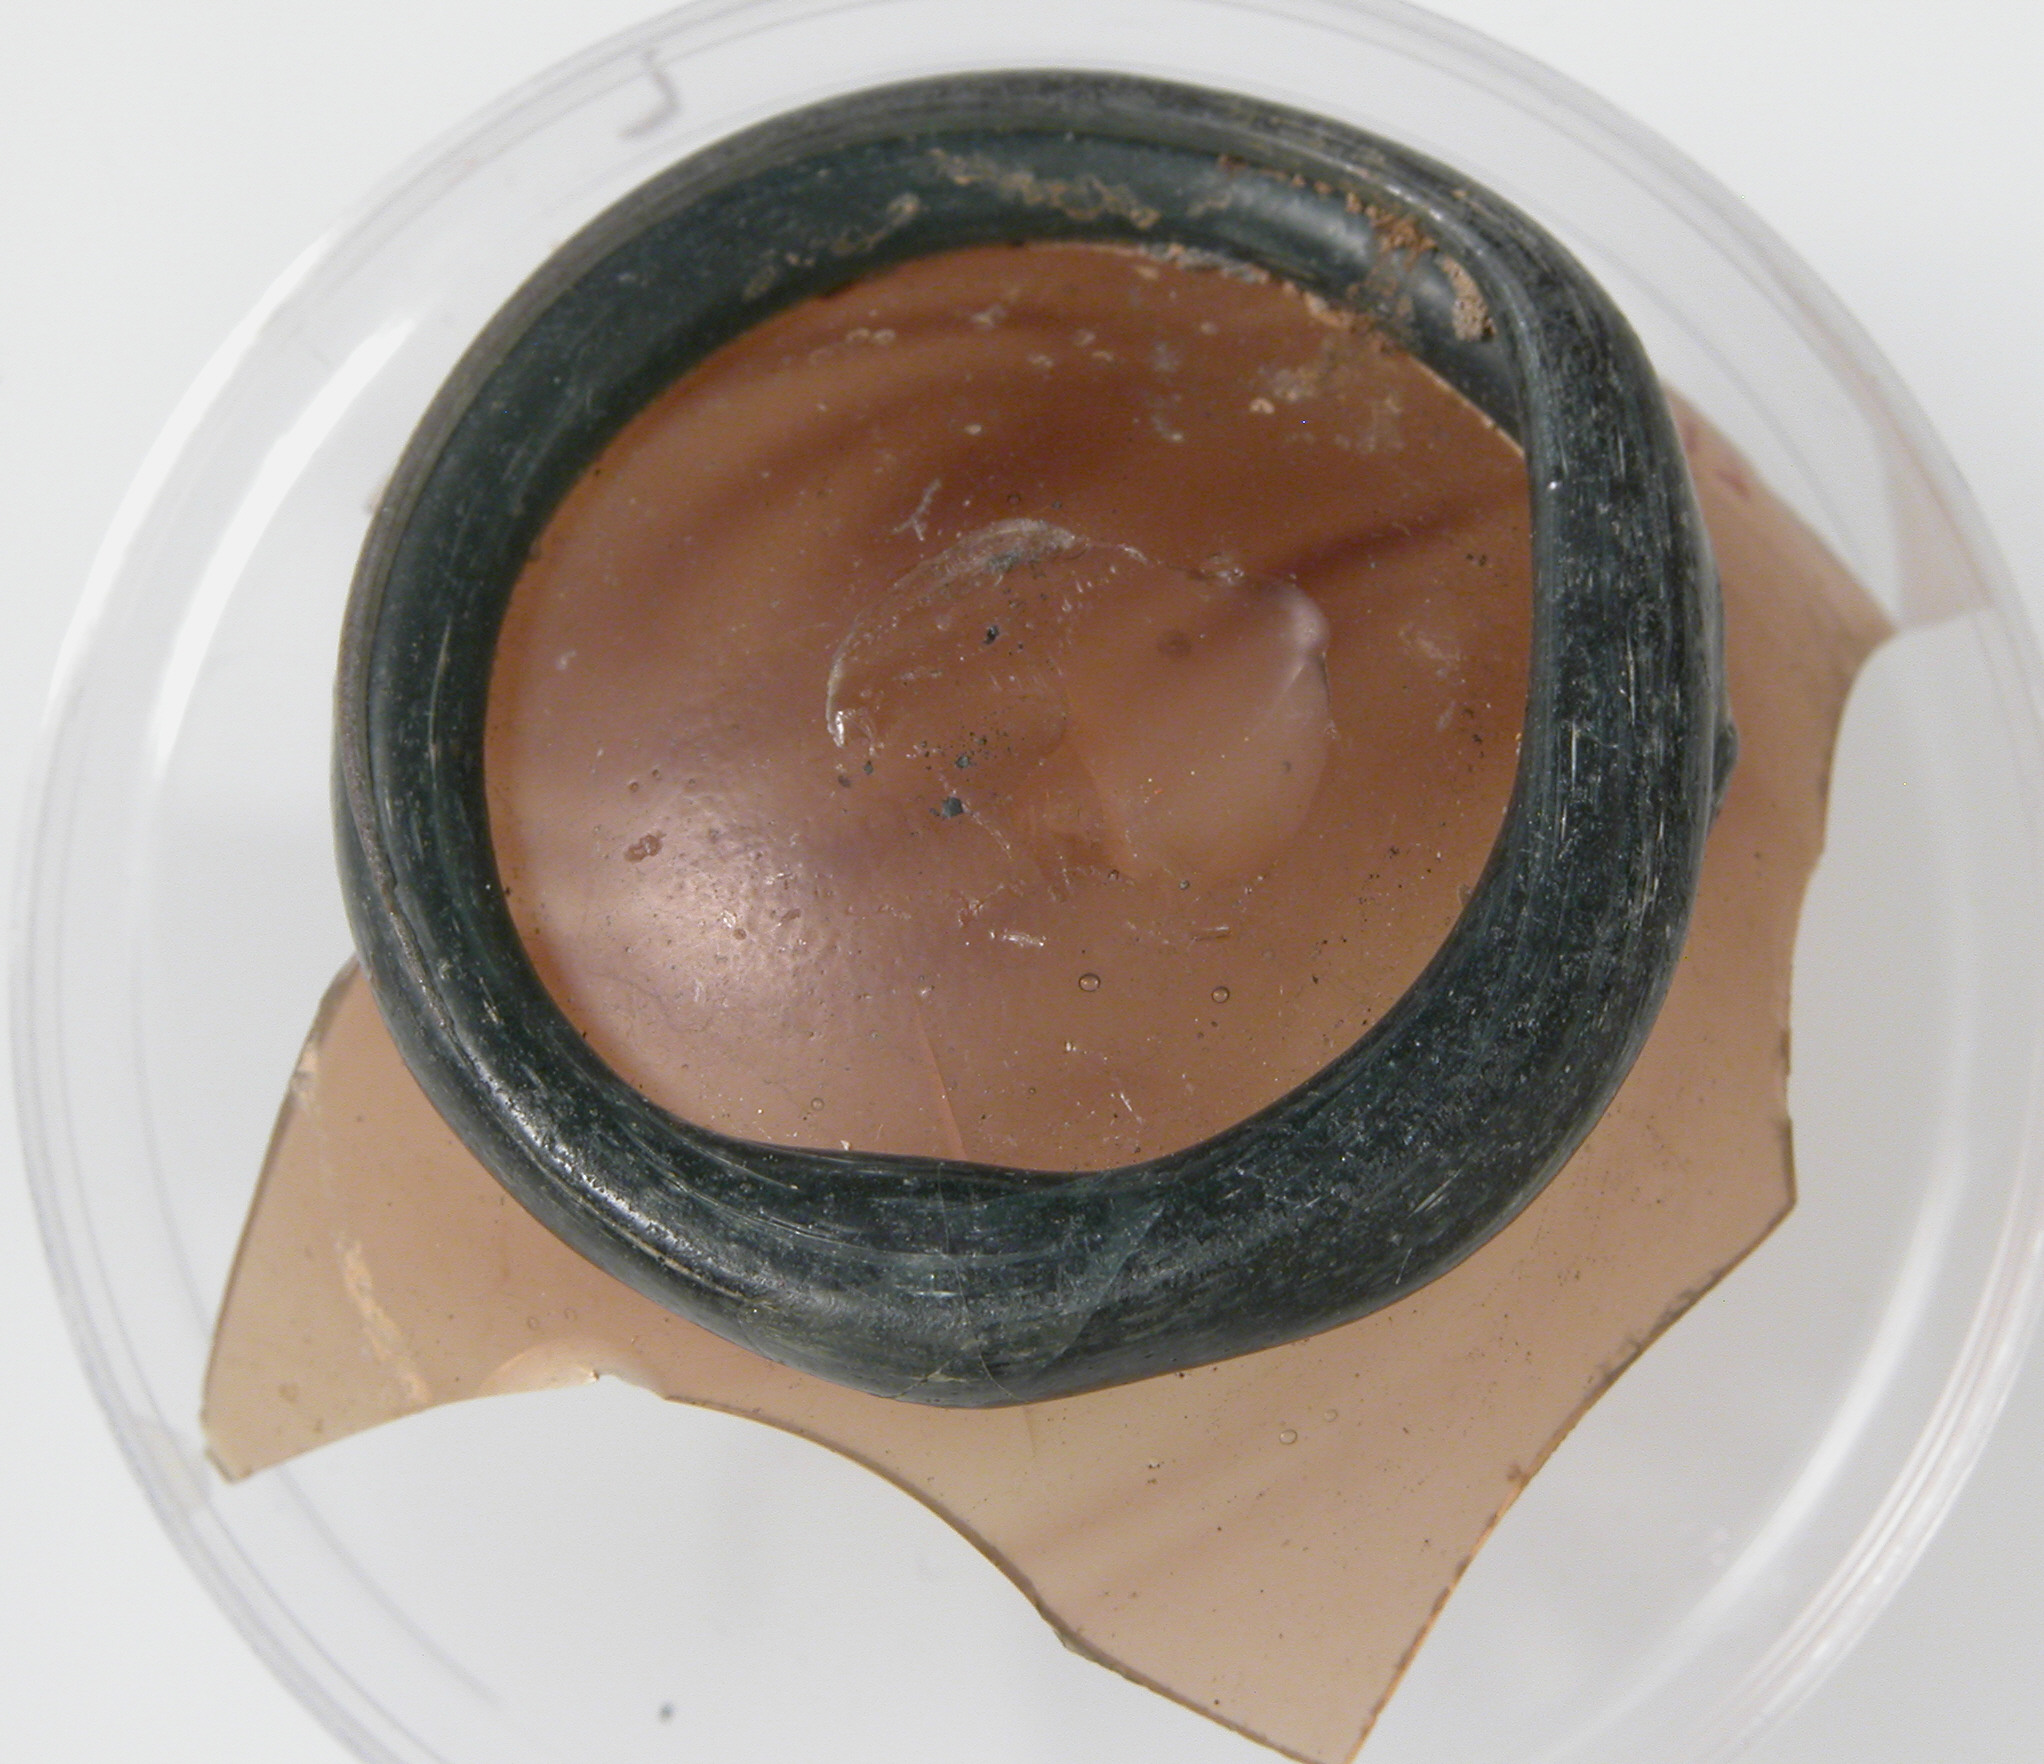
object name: fragment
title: Bottom of a Vessel with Foot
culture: coptic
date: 301-433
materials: glass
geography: egypt